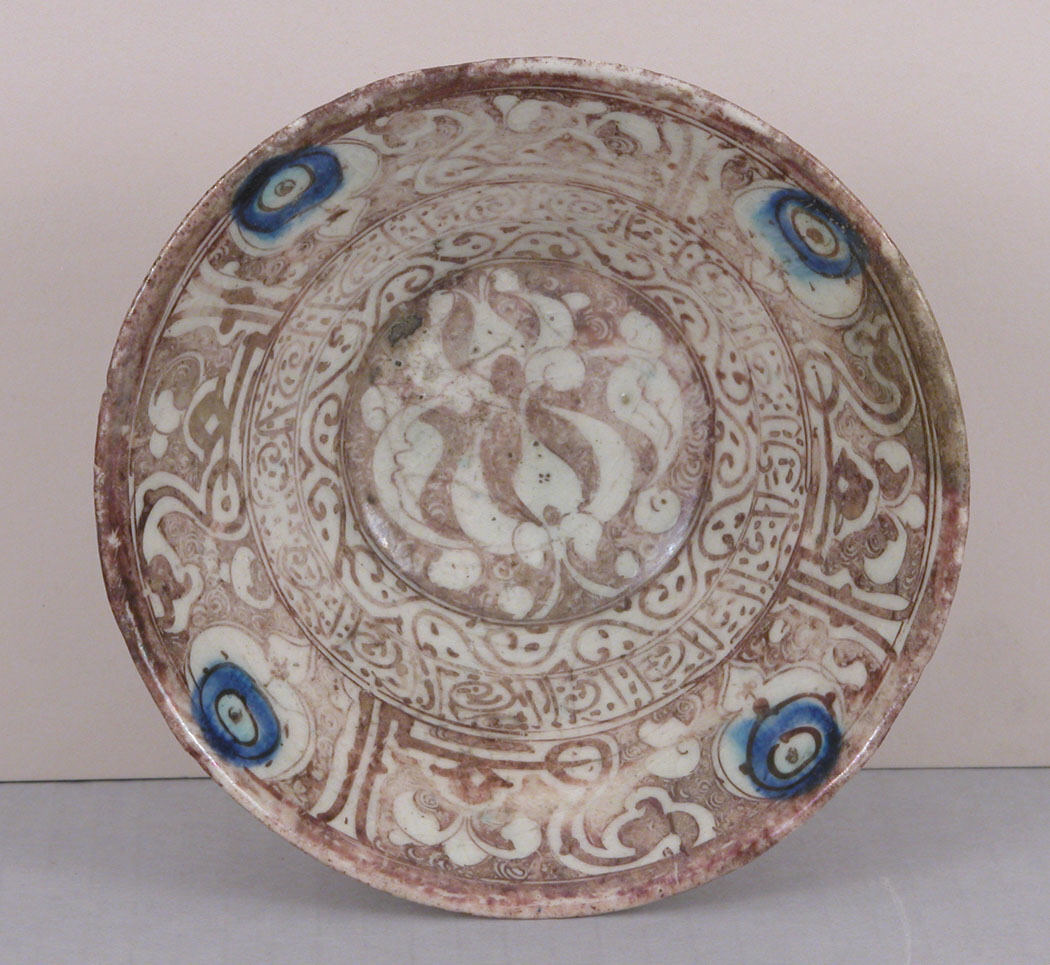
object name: bowl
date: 1101-1200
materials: glaze, stonepaste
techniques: painting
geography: syria